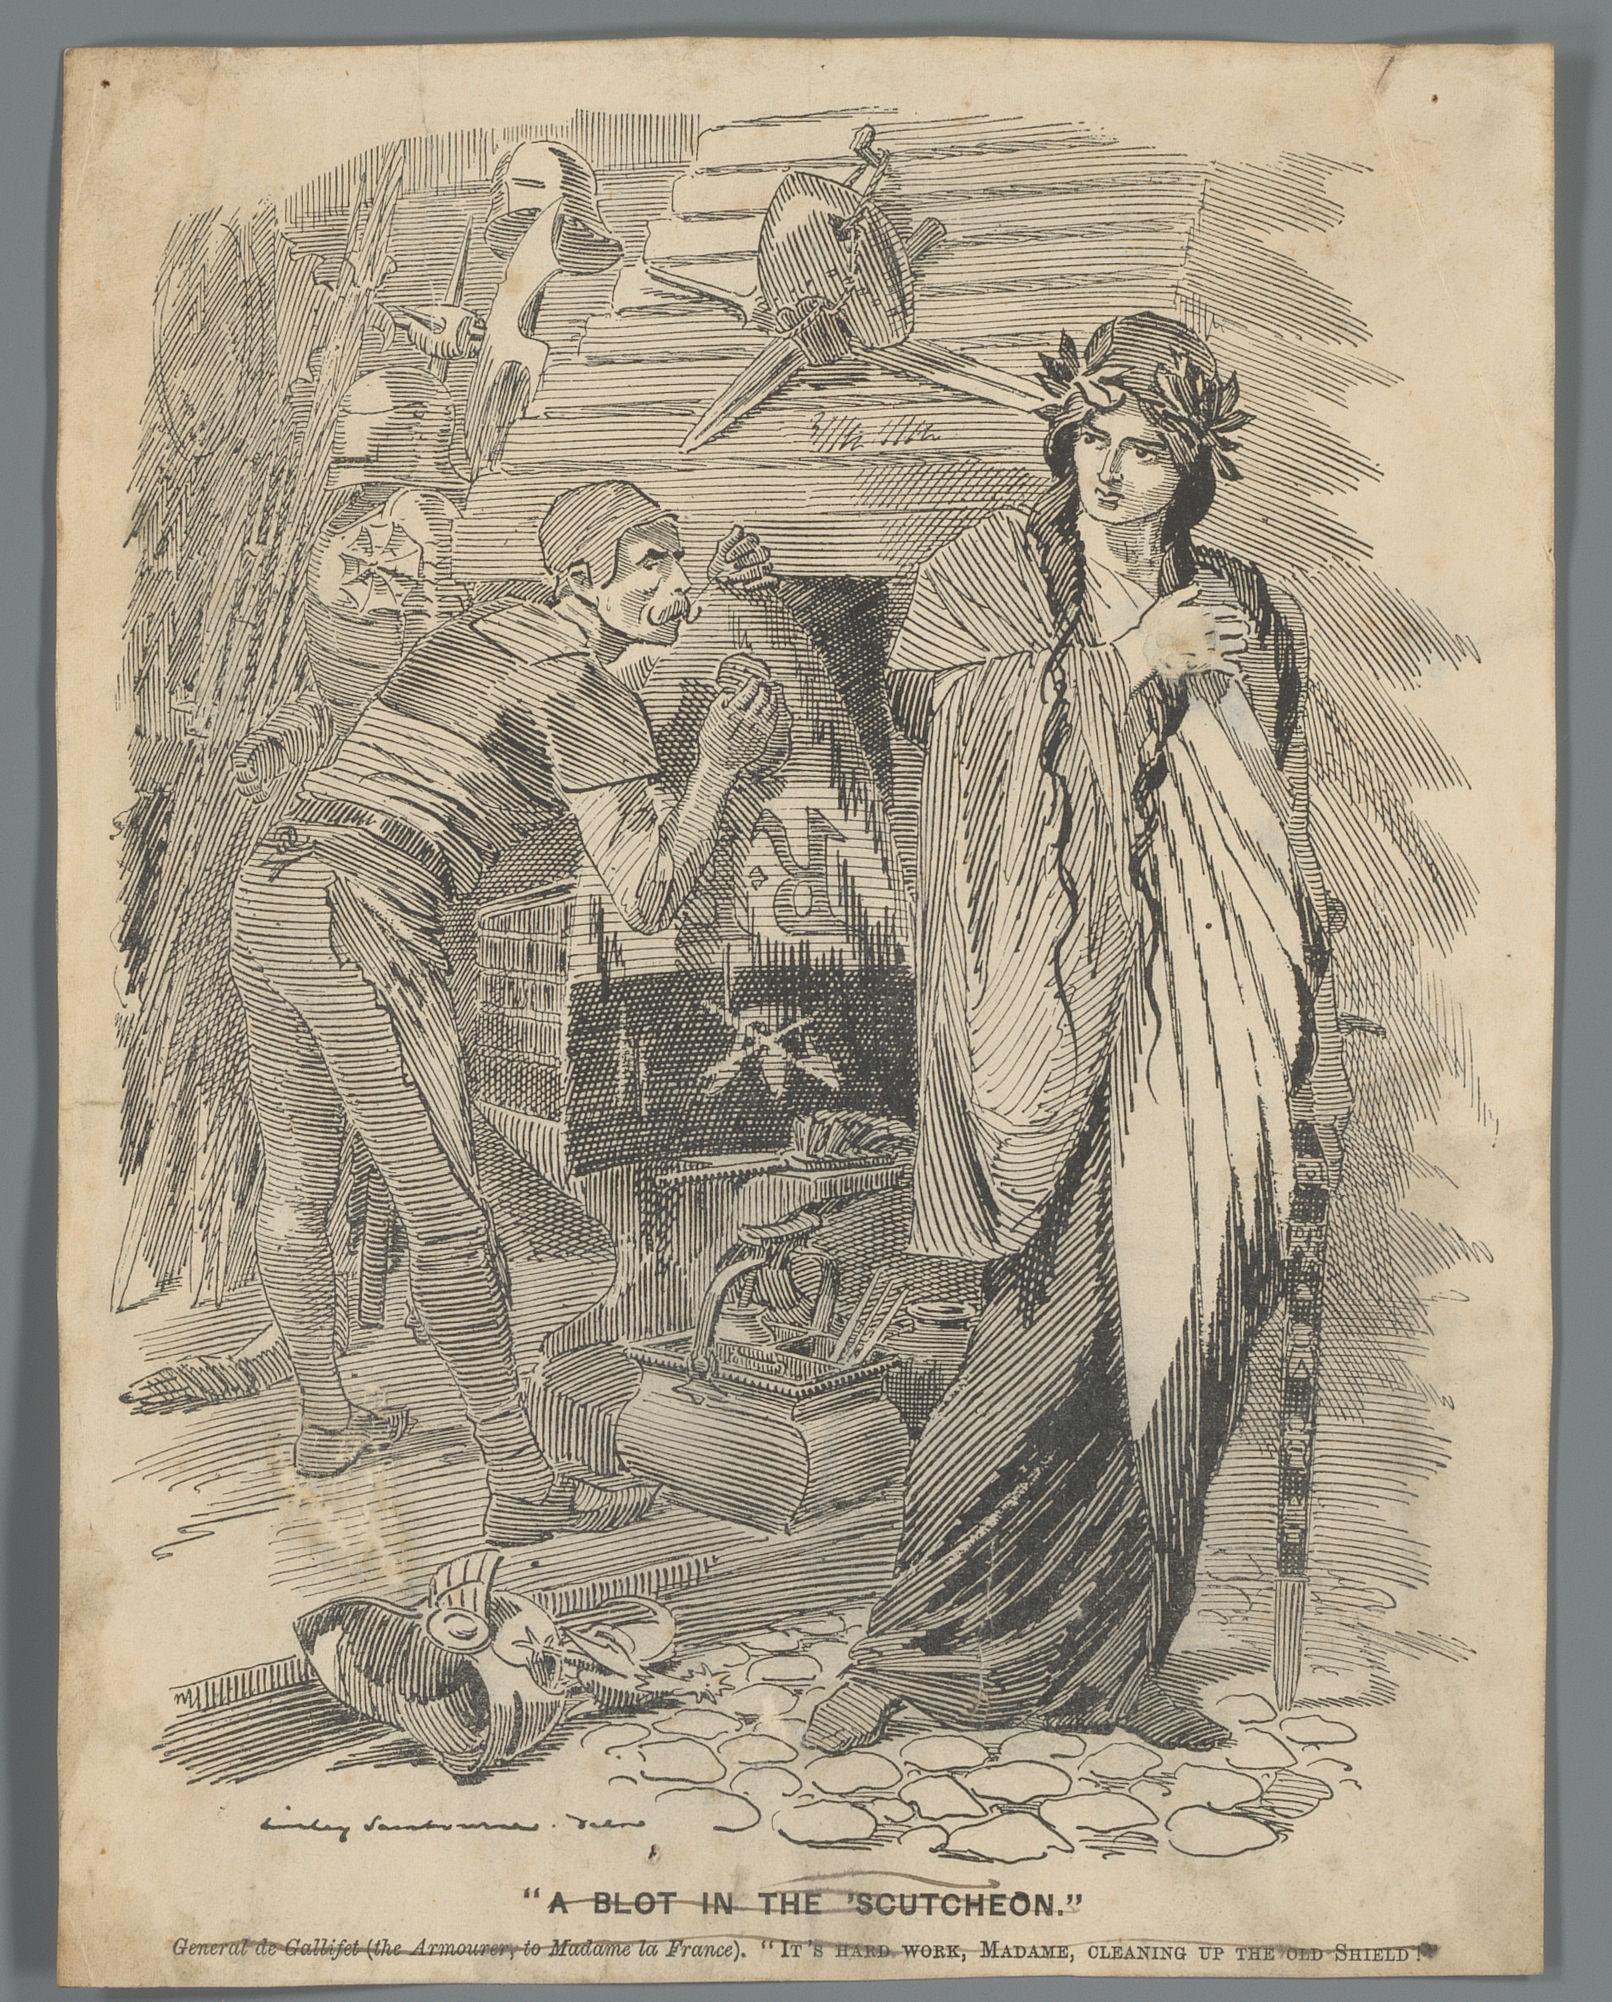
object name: cartoon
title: Generaal Gaston de Galliffet en de Franse maagd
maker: edward linley sambourne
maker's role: draughtsman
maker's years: 1844-1910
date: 1894-1904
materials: paper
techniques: line block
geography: england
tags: personifications of countries, nations, states, districts, etc., political caricatures and satires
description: De Franse generaal Gaston de Galliffet maakt het schild van de Franse maagd schoon. Mogelijk naar aanleiding van de sluiting van de Dreyfus-affaire door de generaal in september 1899. Spotprent uit het satirische tijdschrift Punch, ca. 1894-1904.